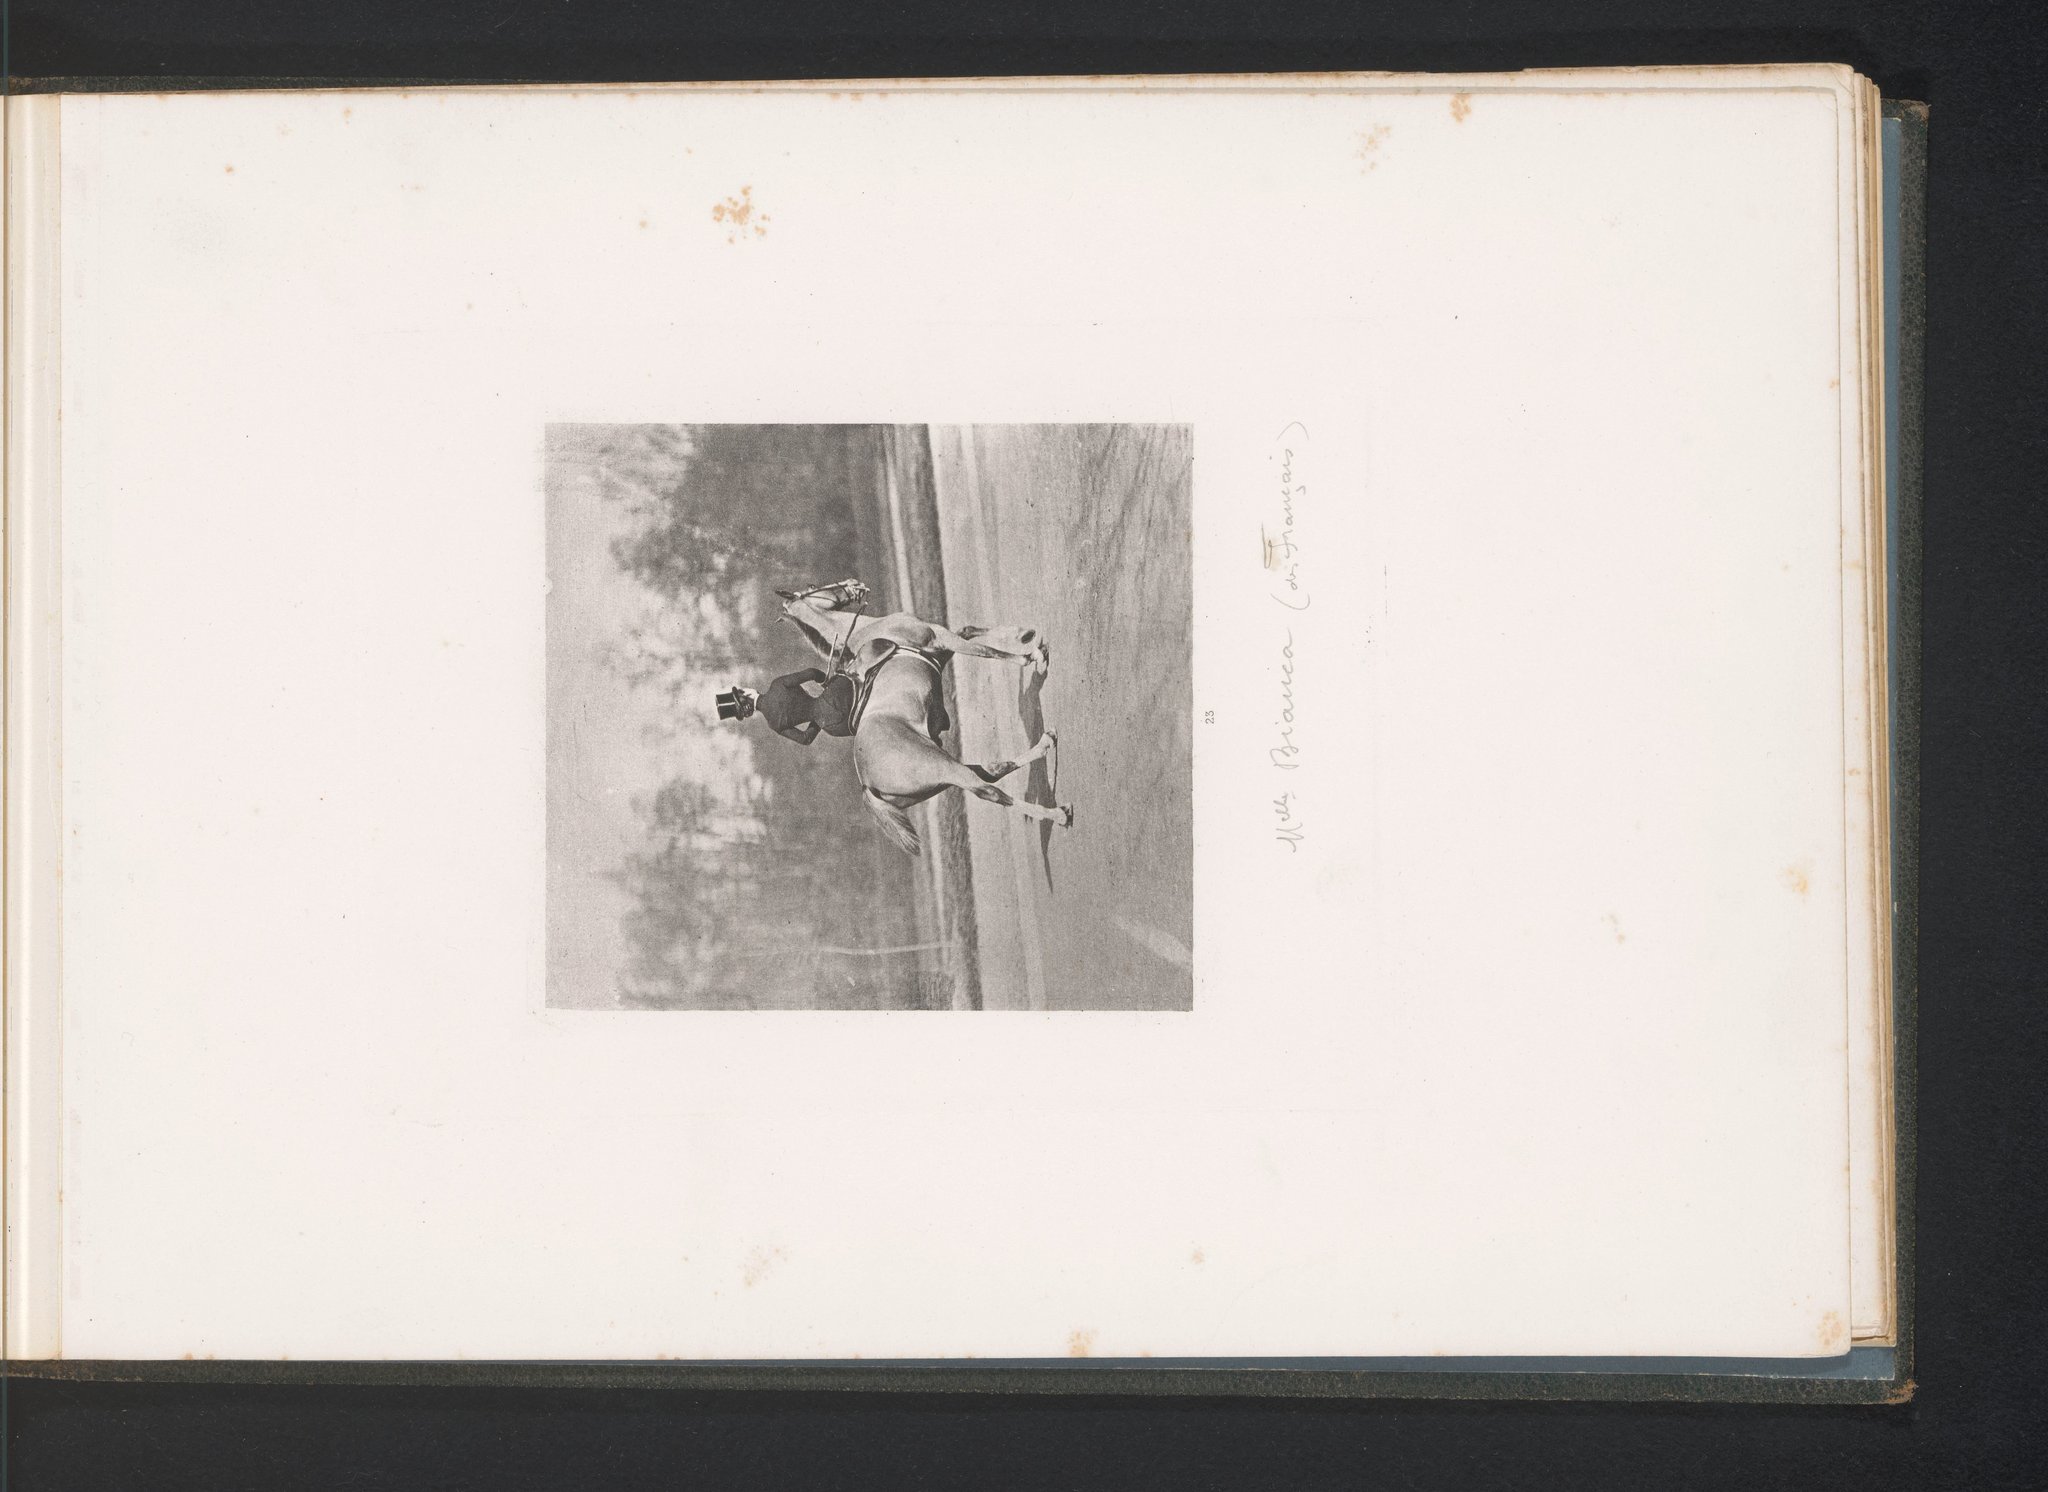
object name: photomechanical print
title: Amazone te paard op de rug gezien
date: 1874-1884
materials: paper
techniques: photoaquatint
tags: riding a horse, ass, or mule; rider, horseman, head-gear: top hat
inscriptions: number: ‘23’, inscription: ‘Mlle. Bianaca (des Français)’